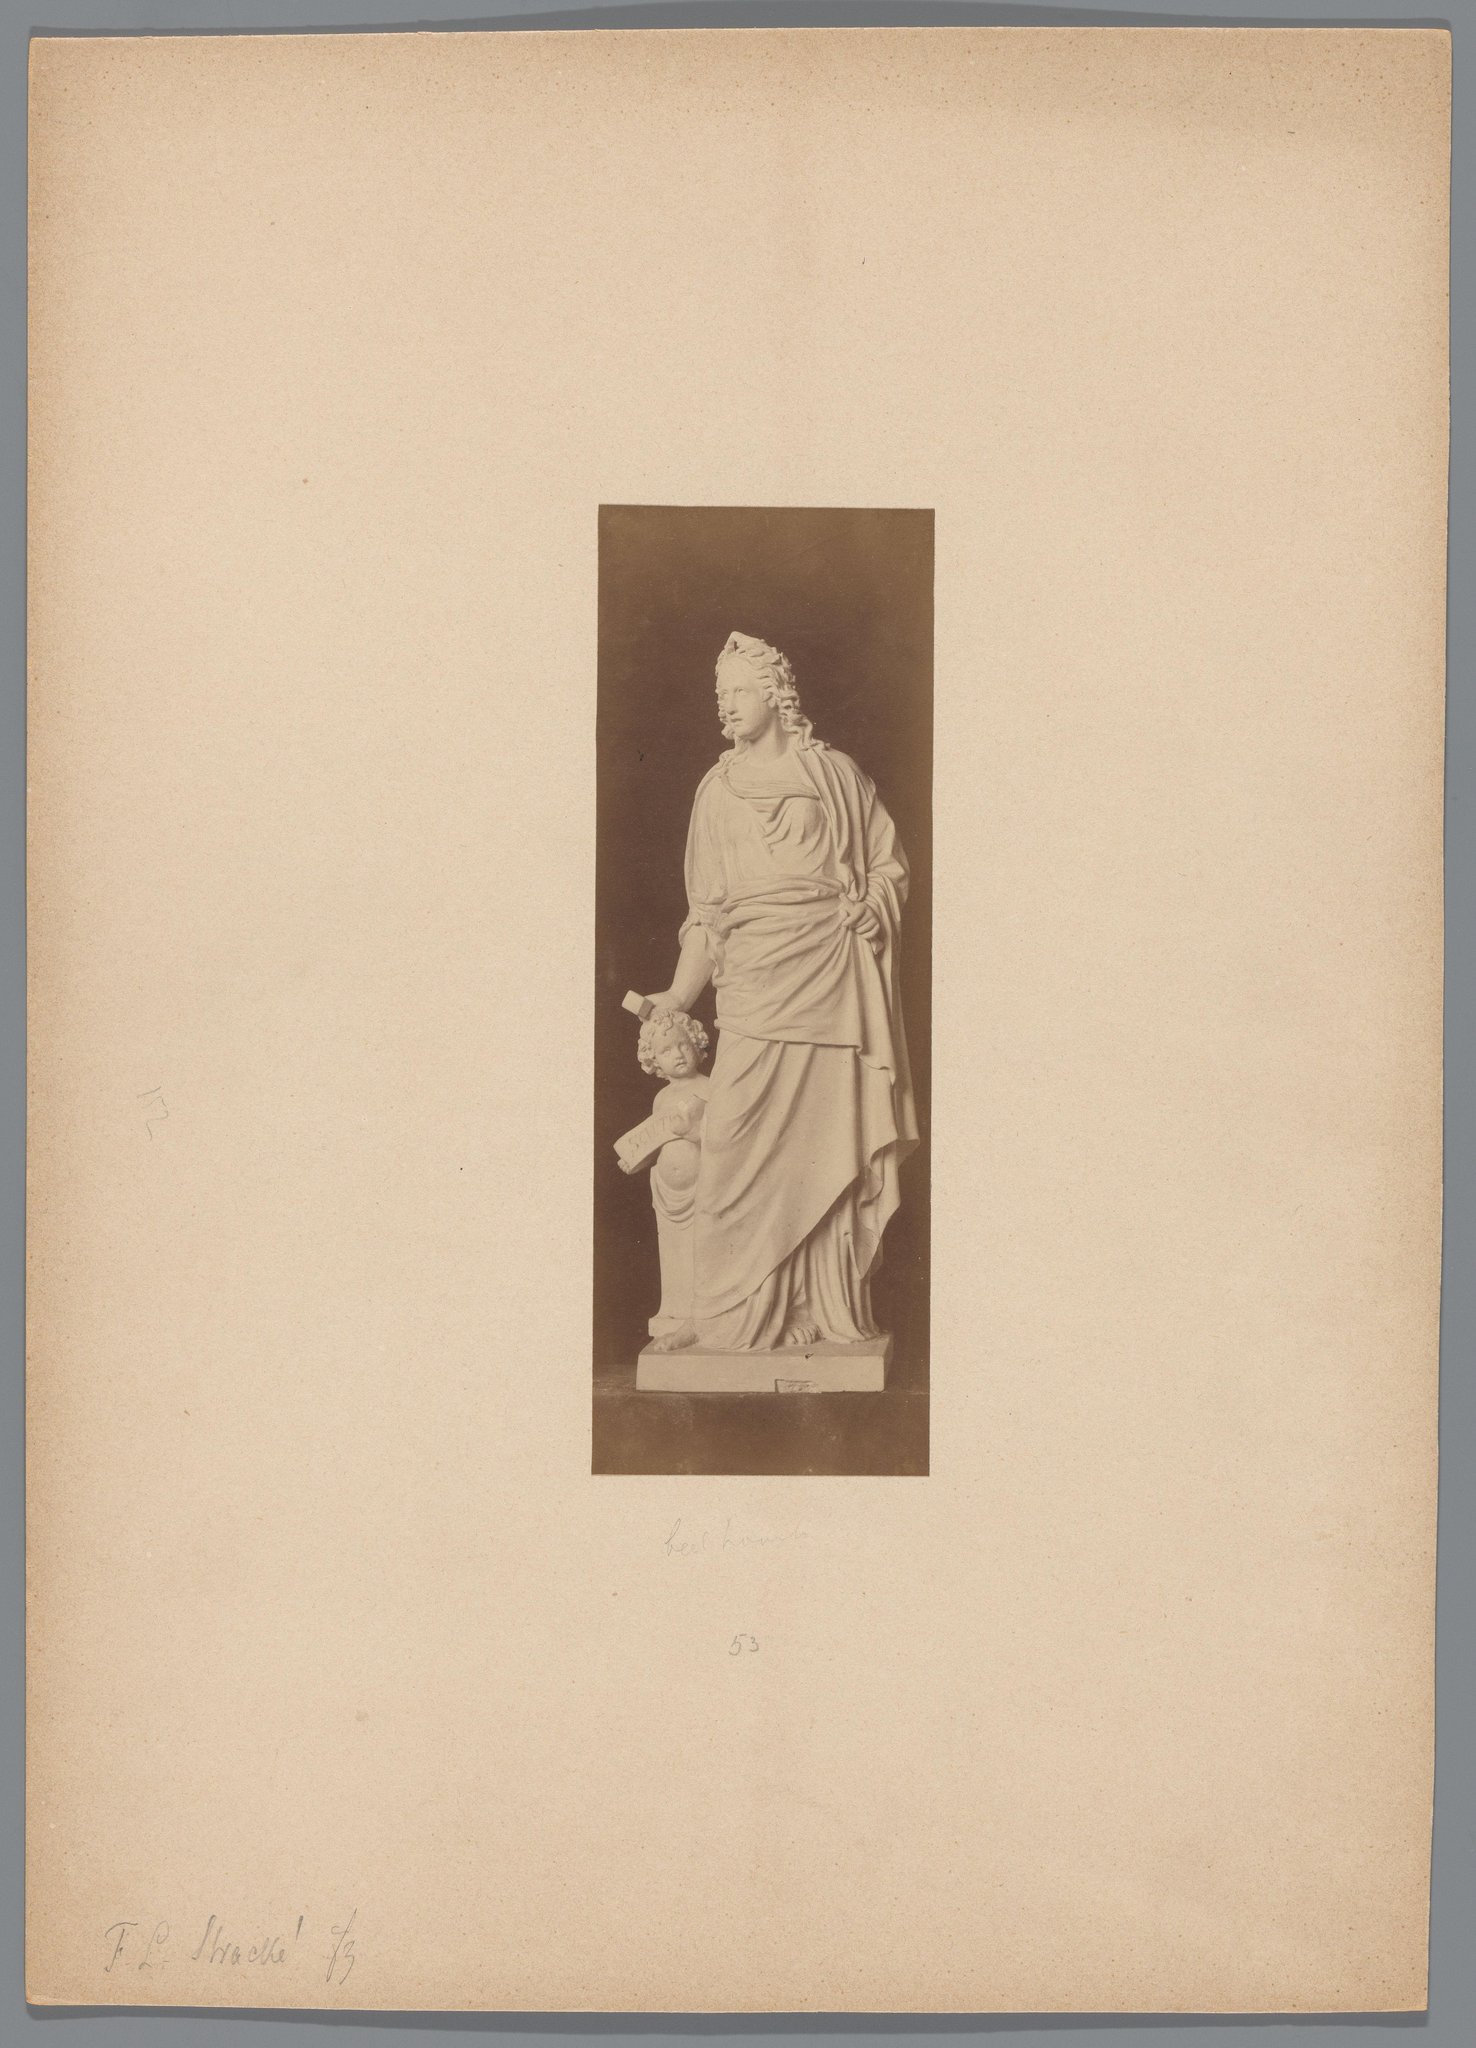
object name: photograph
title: Fotoreproductie van het beeldhouwwerk De Beeldhouwkunst door Franciscus Leonardus Stracké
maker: Anonymous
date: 1880-1887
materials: cardboard, paper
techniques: albumen print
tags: 'sculptura', symbolic representations, allegories and emblems ~ sculpture; 'scoltura' (ripa)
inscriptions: inscription: ‘F. L. Stracké 73’, collector's mark: Lugt 2228, inscription: ‘beeldhouwe/ 53/ 152’